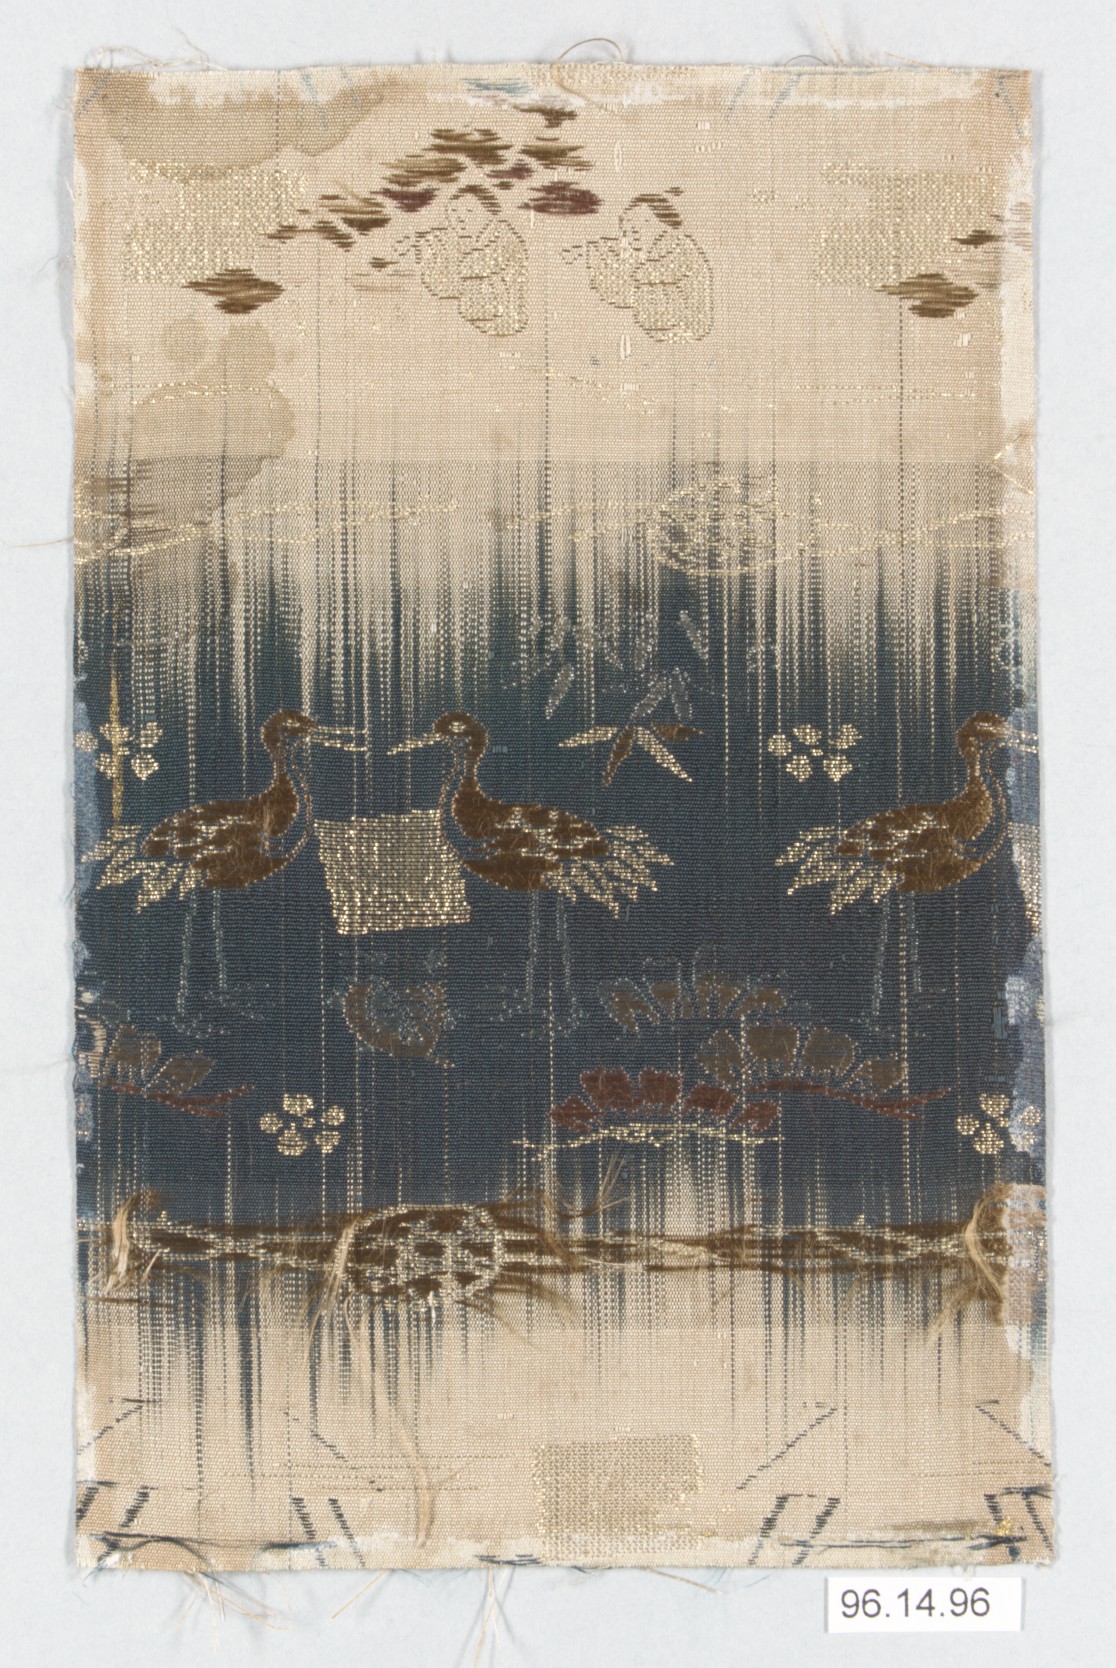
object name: piece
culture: japanese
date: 1701-1800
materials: metal thread, silk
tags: human figures